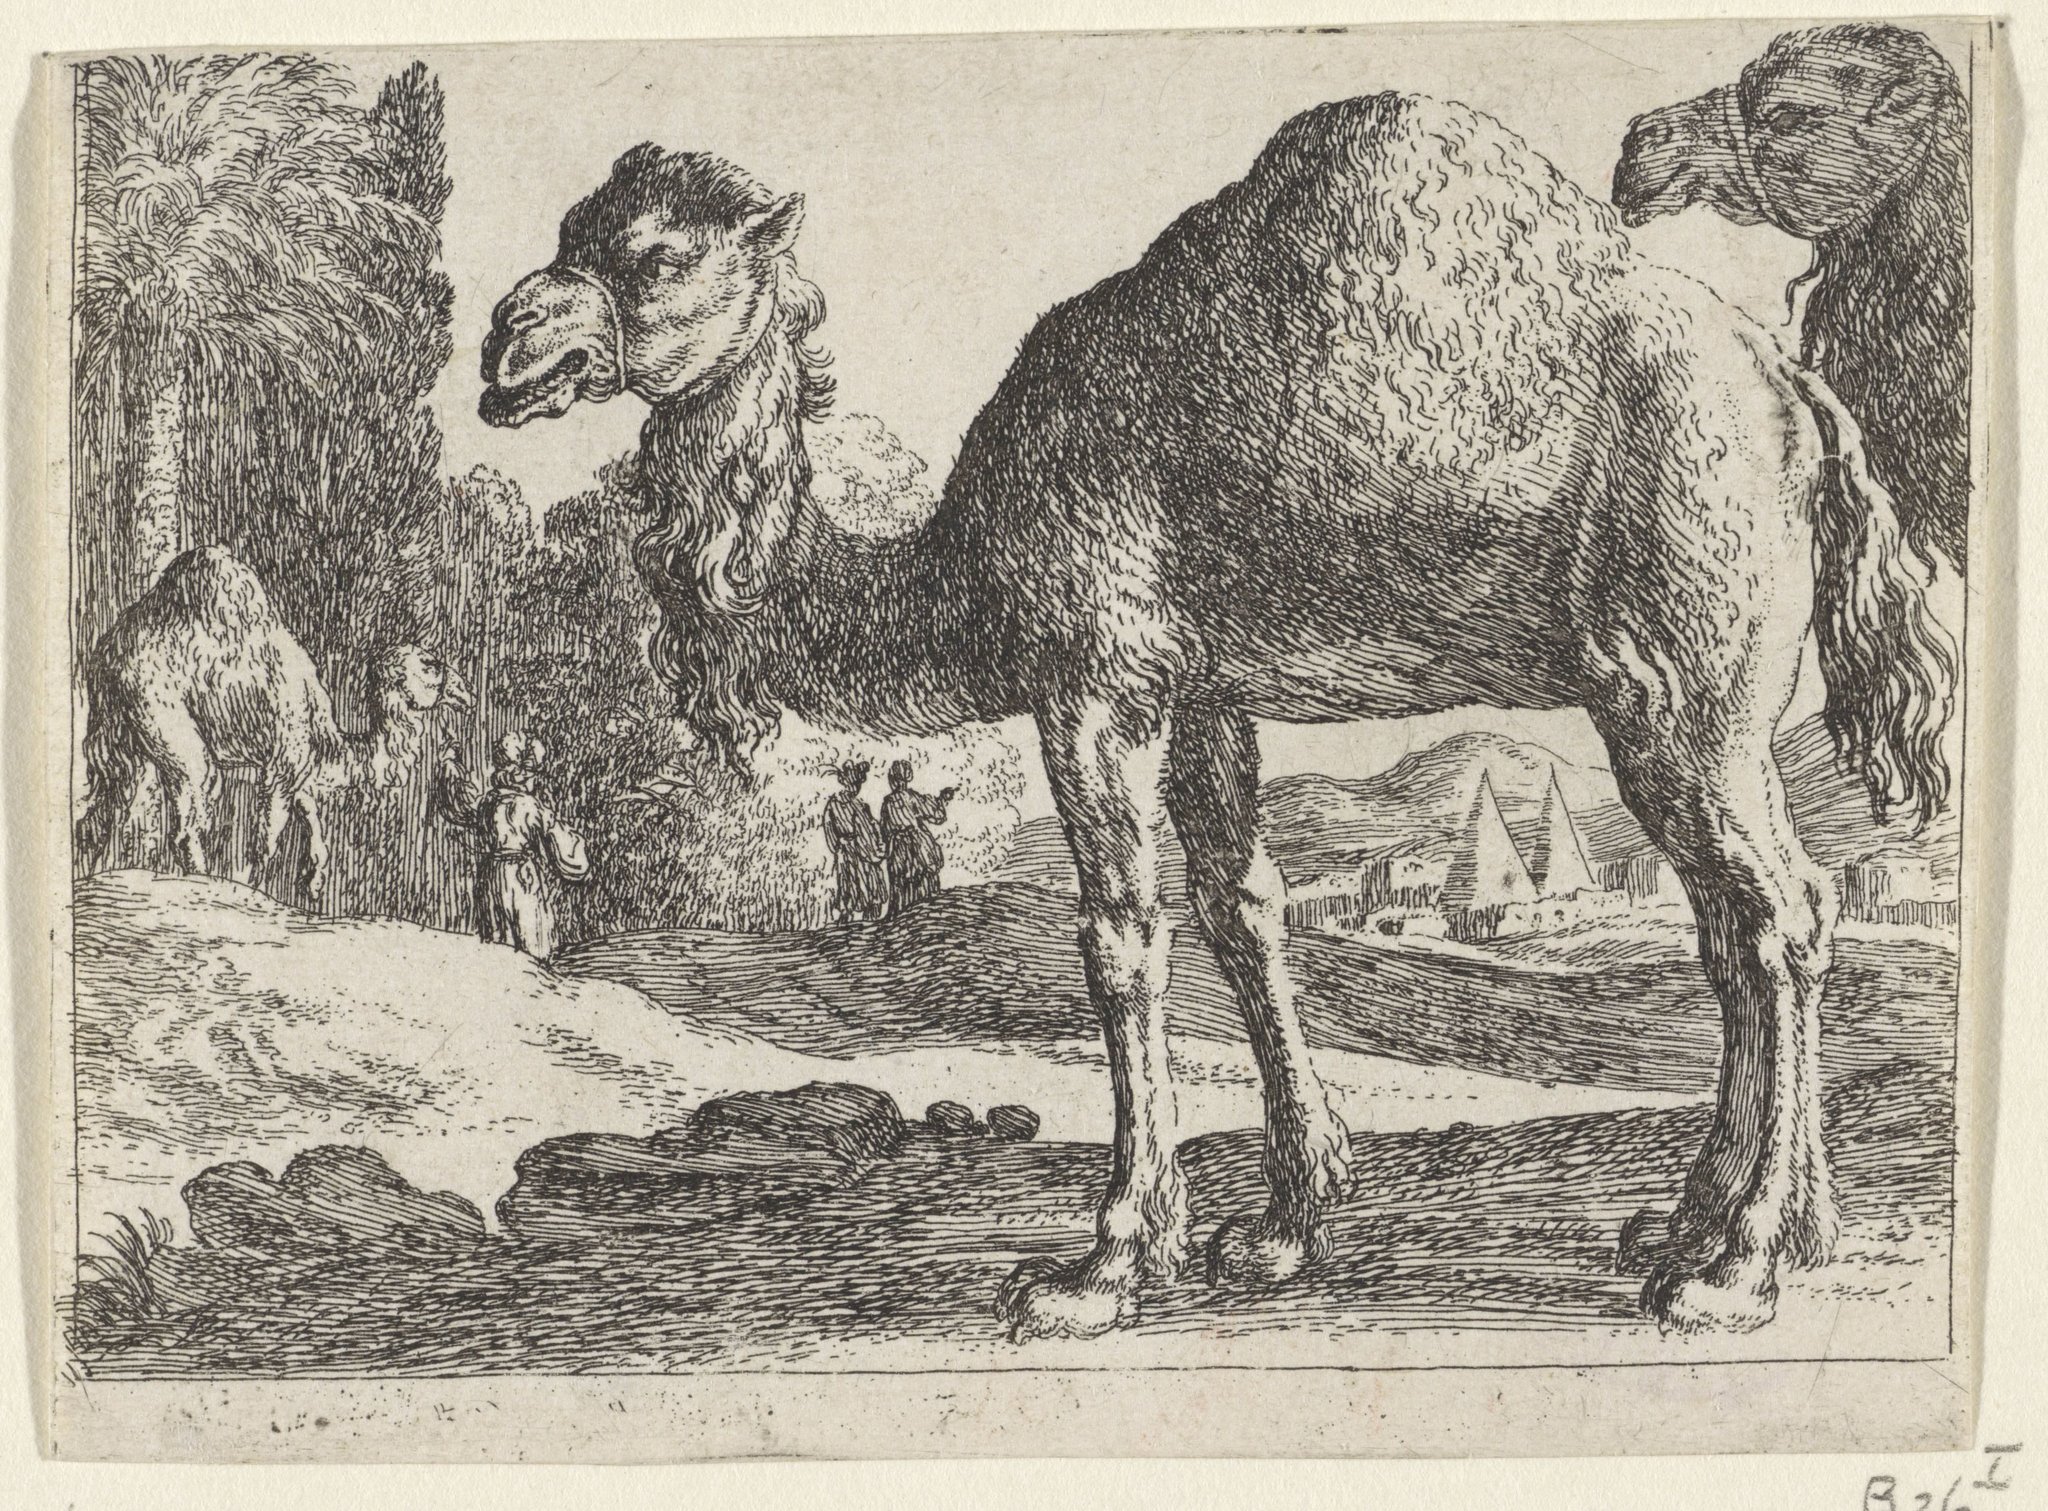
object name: print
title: Landschappen met dieren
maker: herman van swanevelt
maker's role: draughtsman, painter, print maker, publisher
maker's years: 1603-1655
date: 1636-1655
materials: paper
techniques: etching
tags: hoofed animals: camel, landscapes, herding, herdsman, herdswoman, shepherd, shepherdess, cowherd, etc., pyramid (historical grave form)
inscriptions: collector's mark: Lugt 240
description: Achter twee kamelen leidt een man een derde kameel aan een teugel. In de verte staan twee piramidevormige bouwwerken.